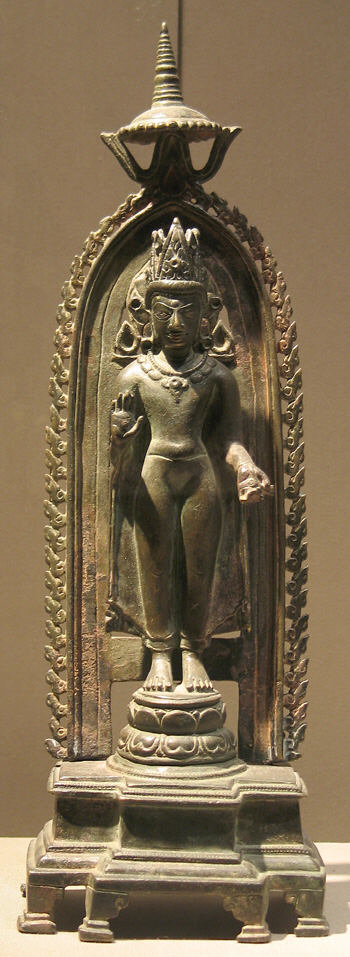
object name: shrine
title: Crowned and Jeweled Buddha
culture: indian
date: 1001-1033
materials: bronze, copper, silver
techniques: inlay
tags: buddhism,buddha